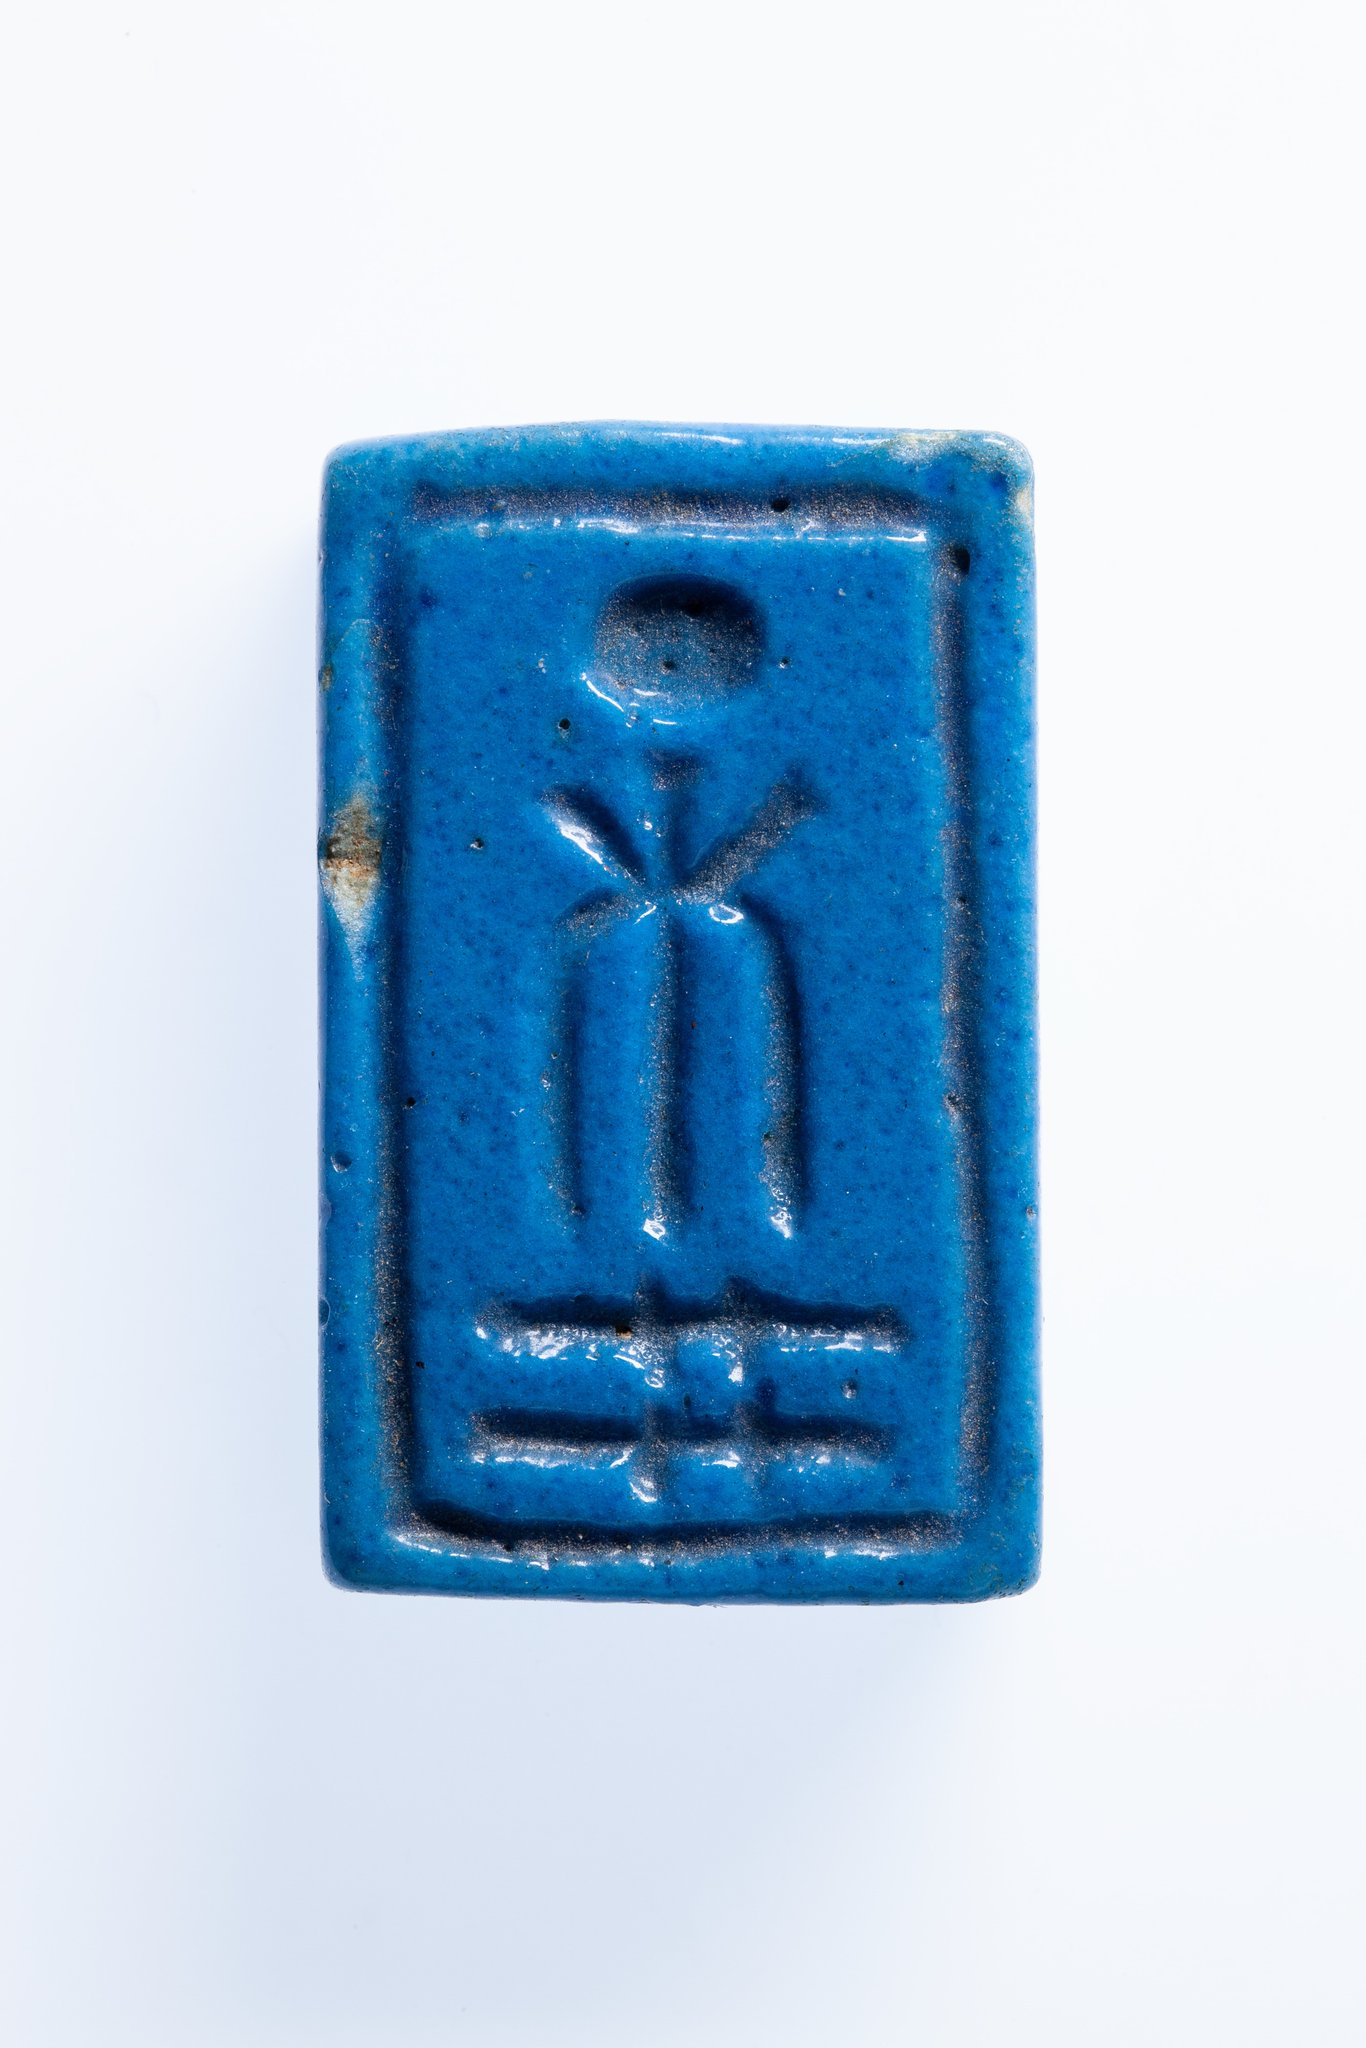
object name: foundation deposit, plaque, rectangular, ramesses iv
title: Inscribed Rectangular Plaque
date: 1153-1147 BCE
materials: faience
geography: egypt